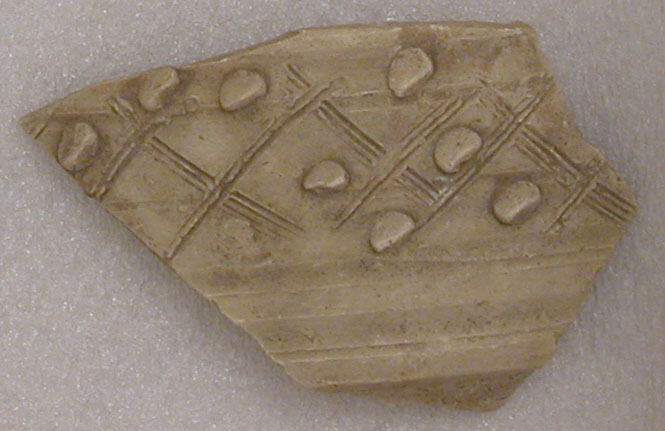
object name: fragment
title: Ceramic Fragment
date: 701-900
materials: earthenware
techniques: incising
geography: iraq